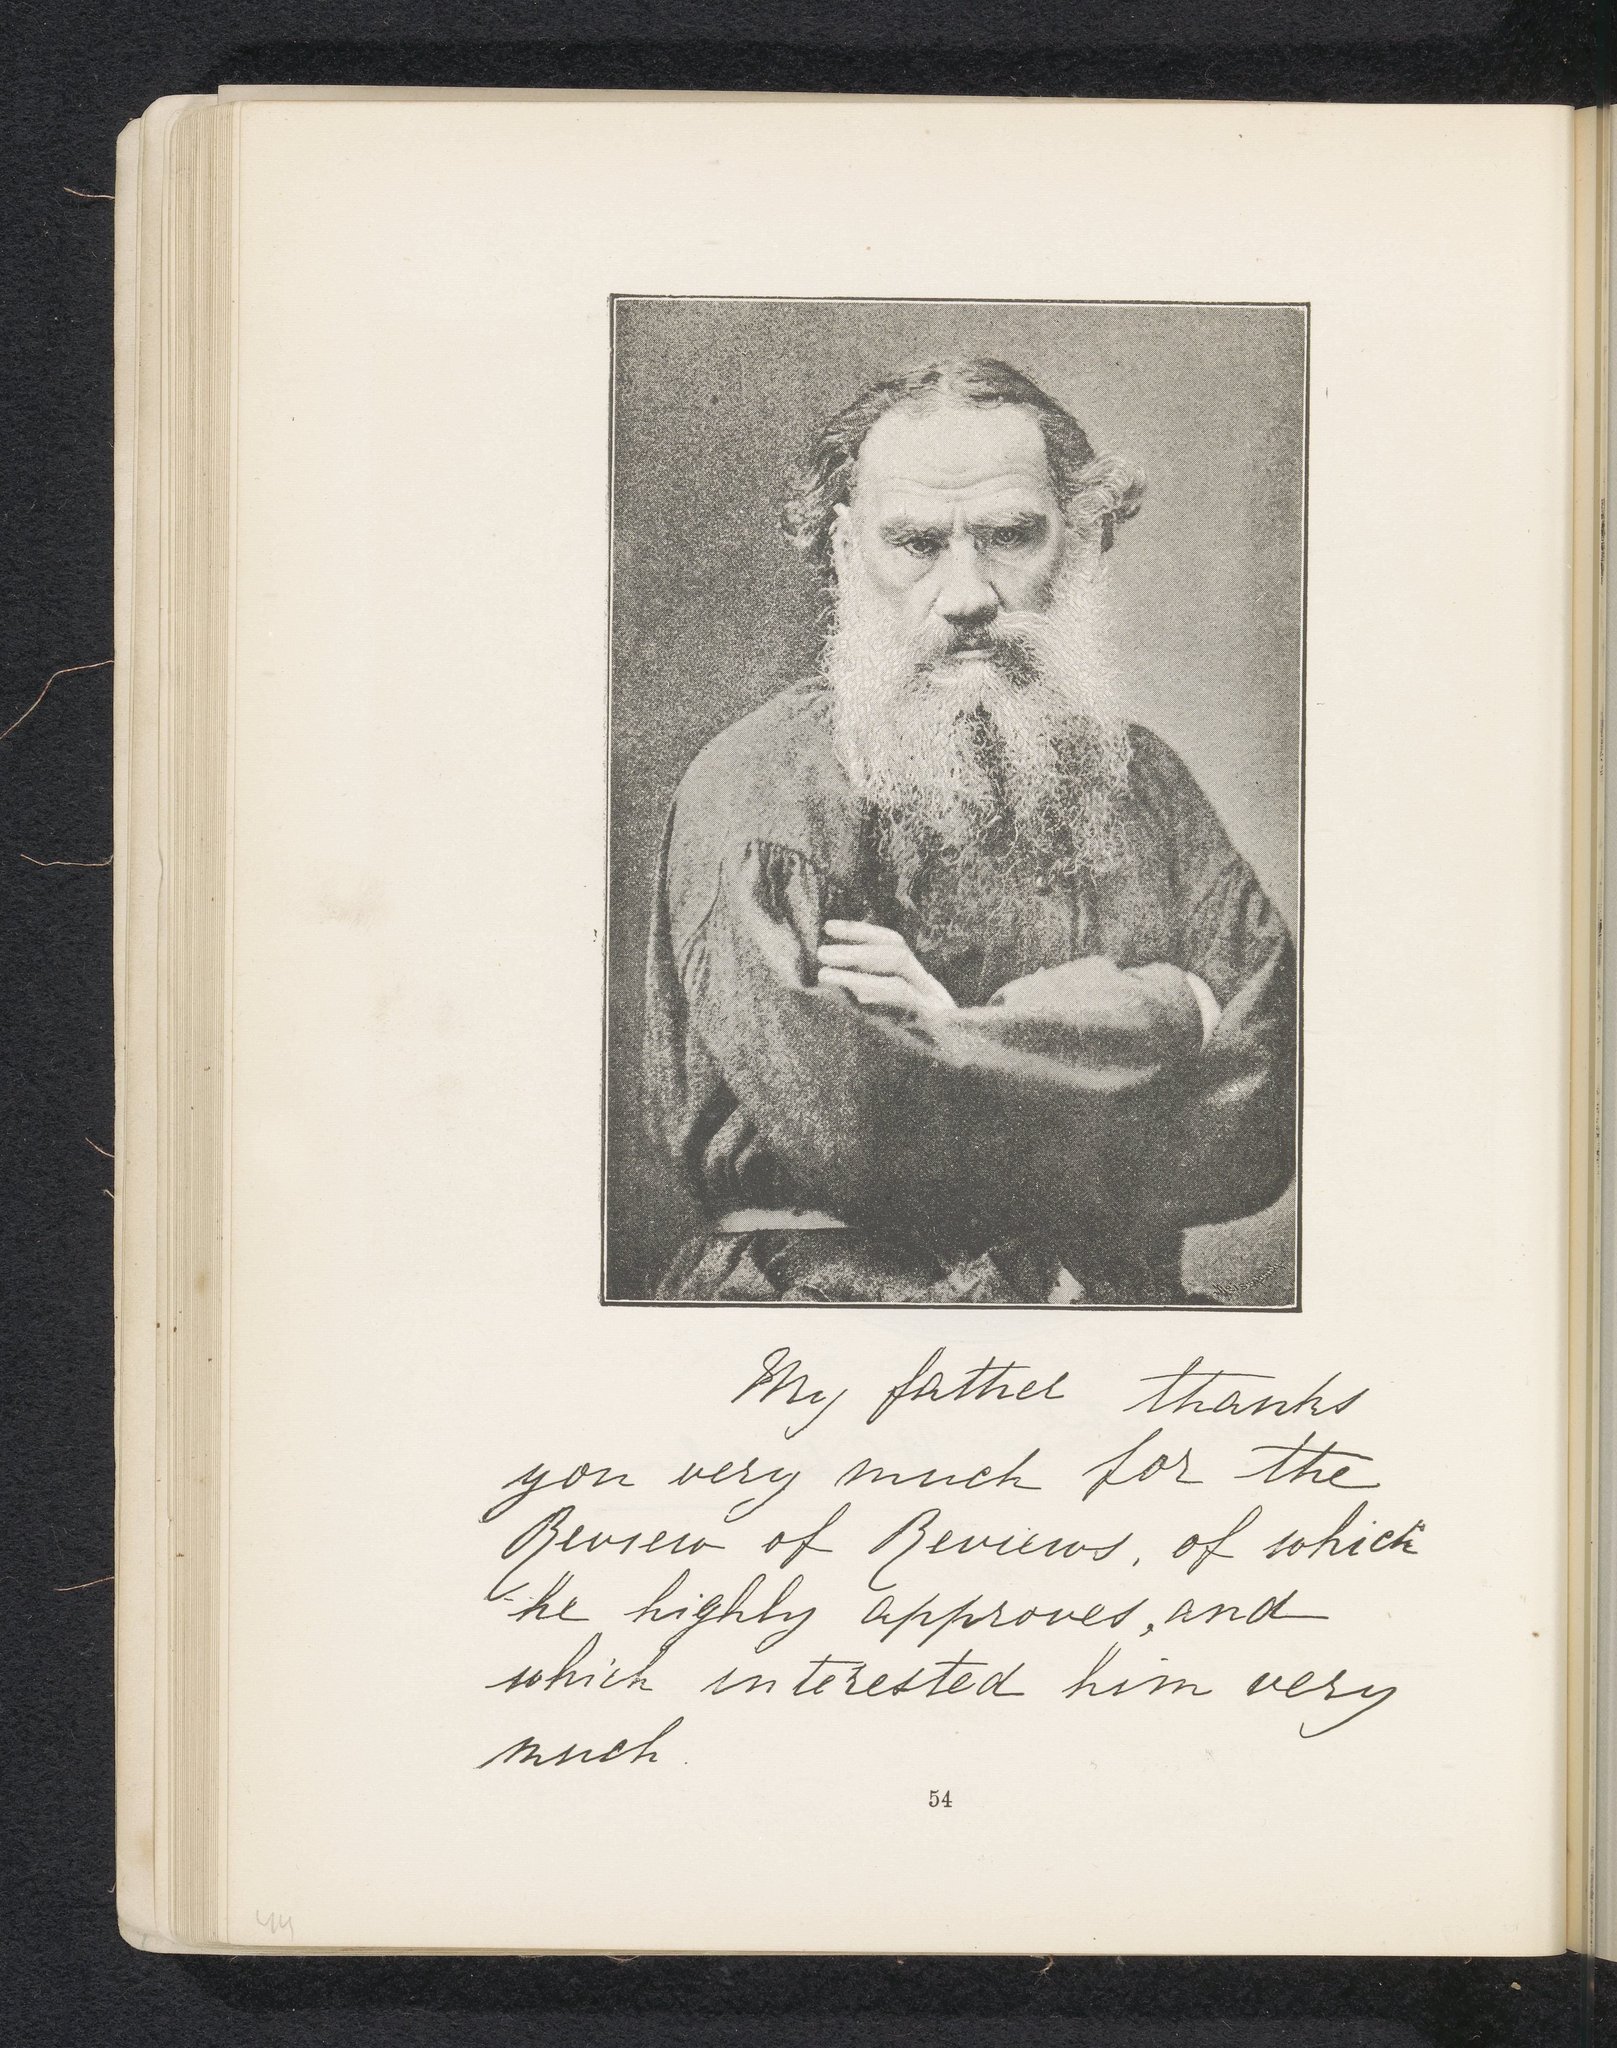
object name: photomechanical print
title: Portret van Lev Tolstoj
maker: Anonymous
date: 1881-1891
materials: paper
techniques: autotype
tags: portrait of a writer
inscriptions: inscription